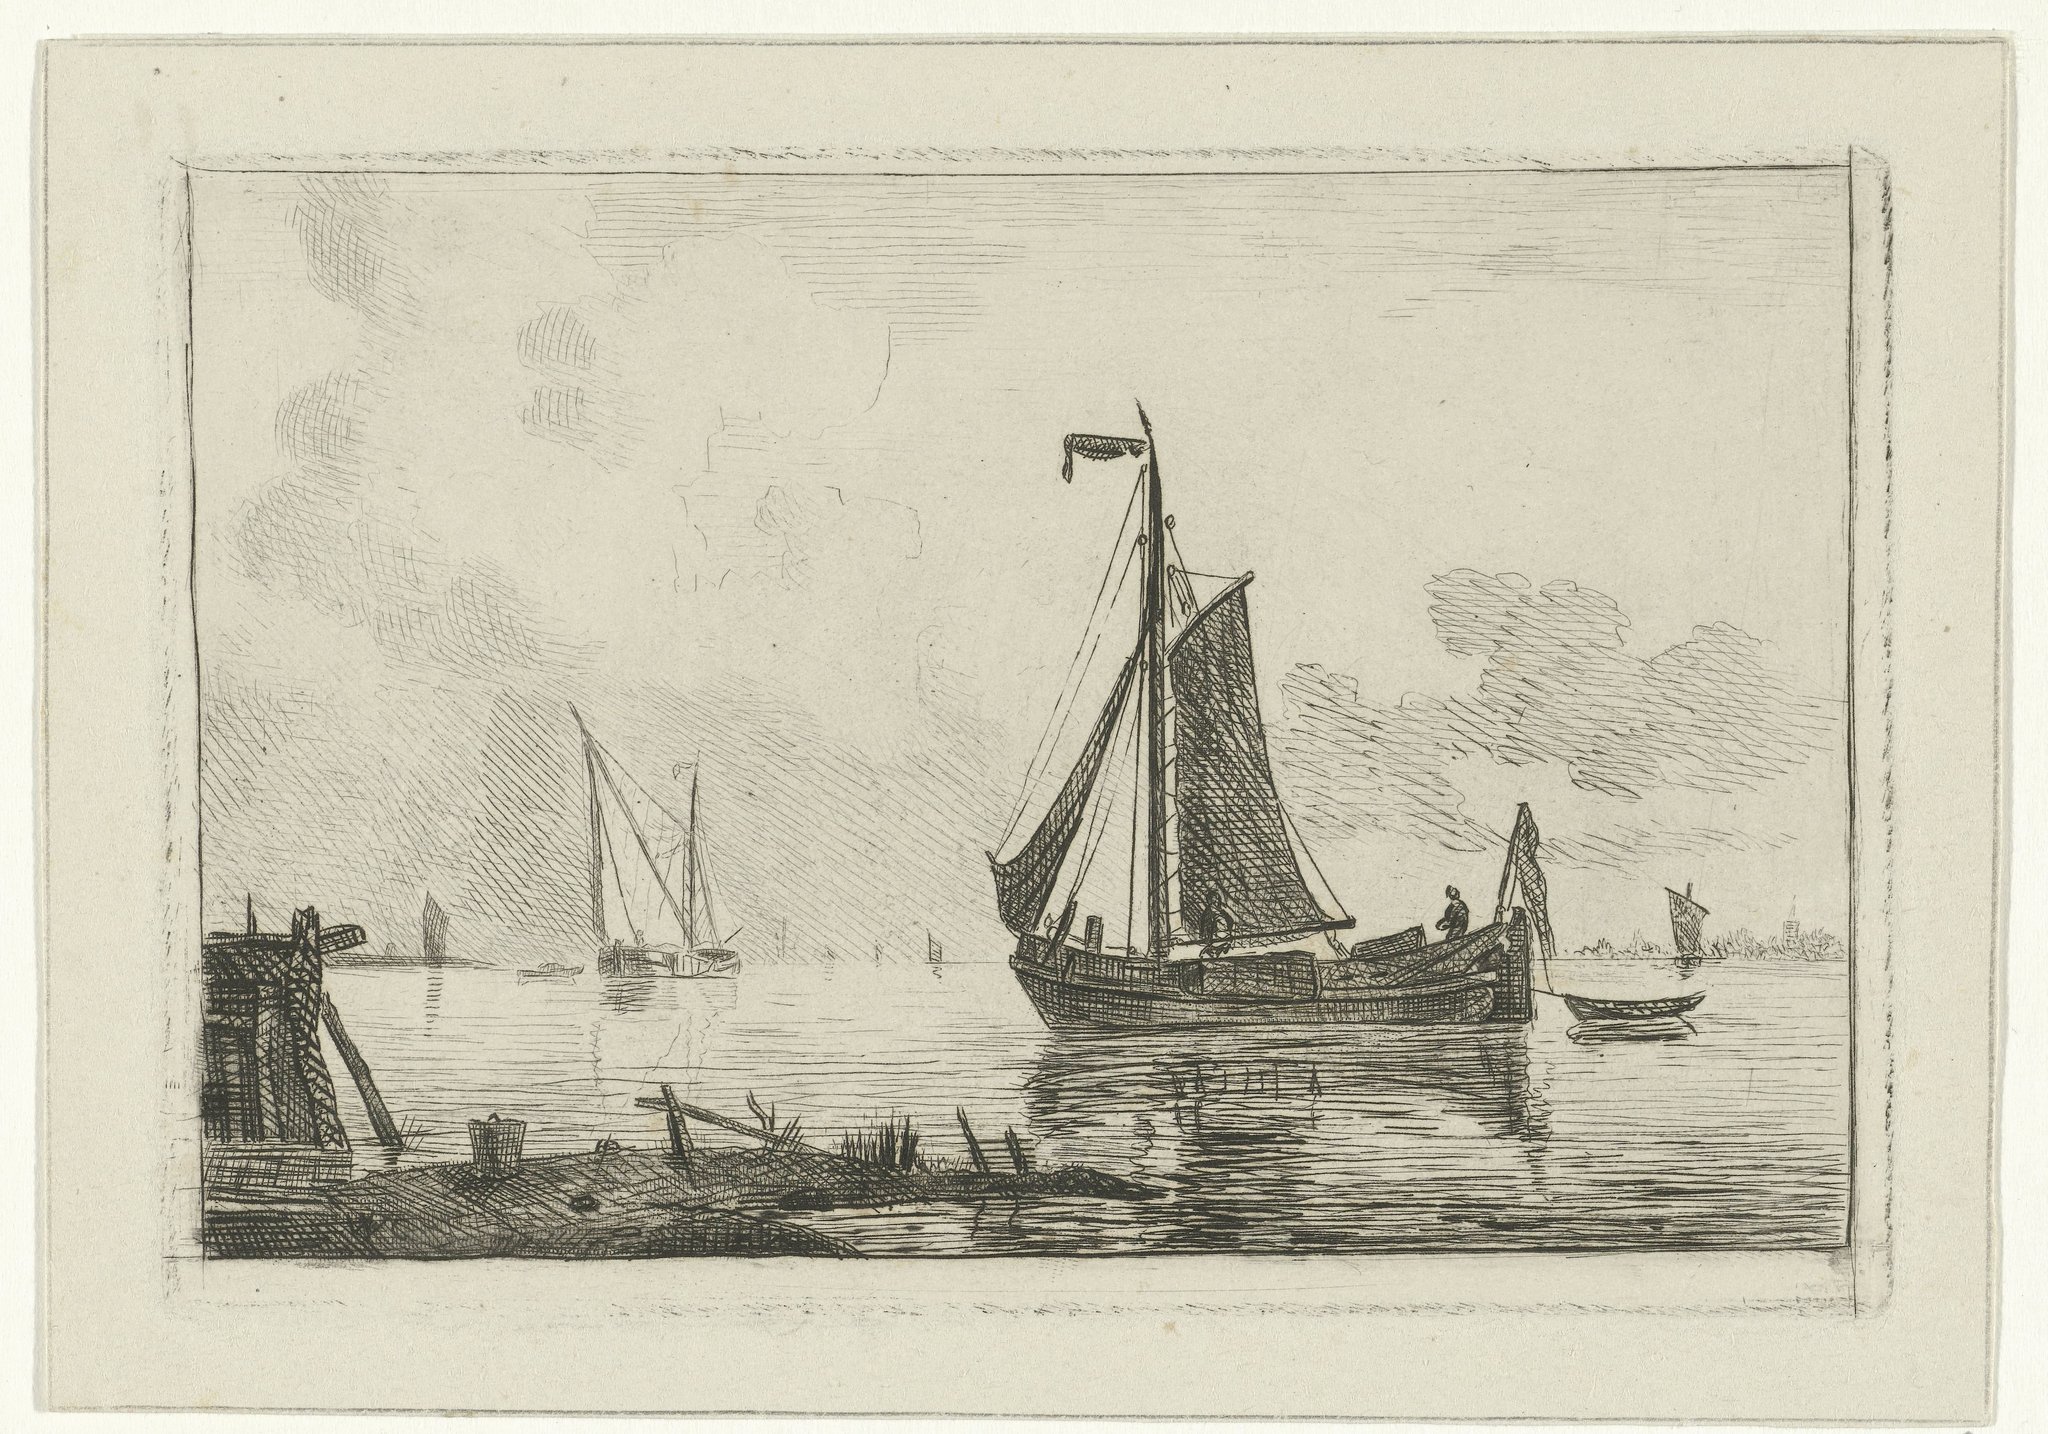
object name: print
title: Riviergezicht met zeilschip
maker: willem gruyter jr.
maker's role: draughtsman, print maker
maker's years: 1817-1880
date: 1832-1880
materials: paper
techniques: engraving, etching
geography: amsterdam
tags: sailing-ship, sailing-boat (+ view ~ vehicle, ship, etc.)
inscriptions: collector's mark: Lugt 2165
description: Riviergezicht met zeilschip op de flank gezien. Links een pier.